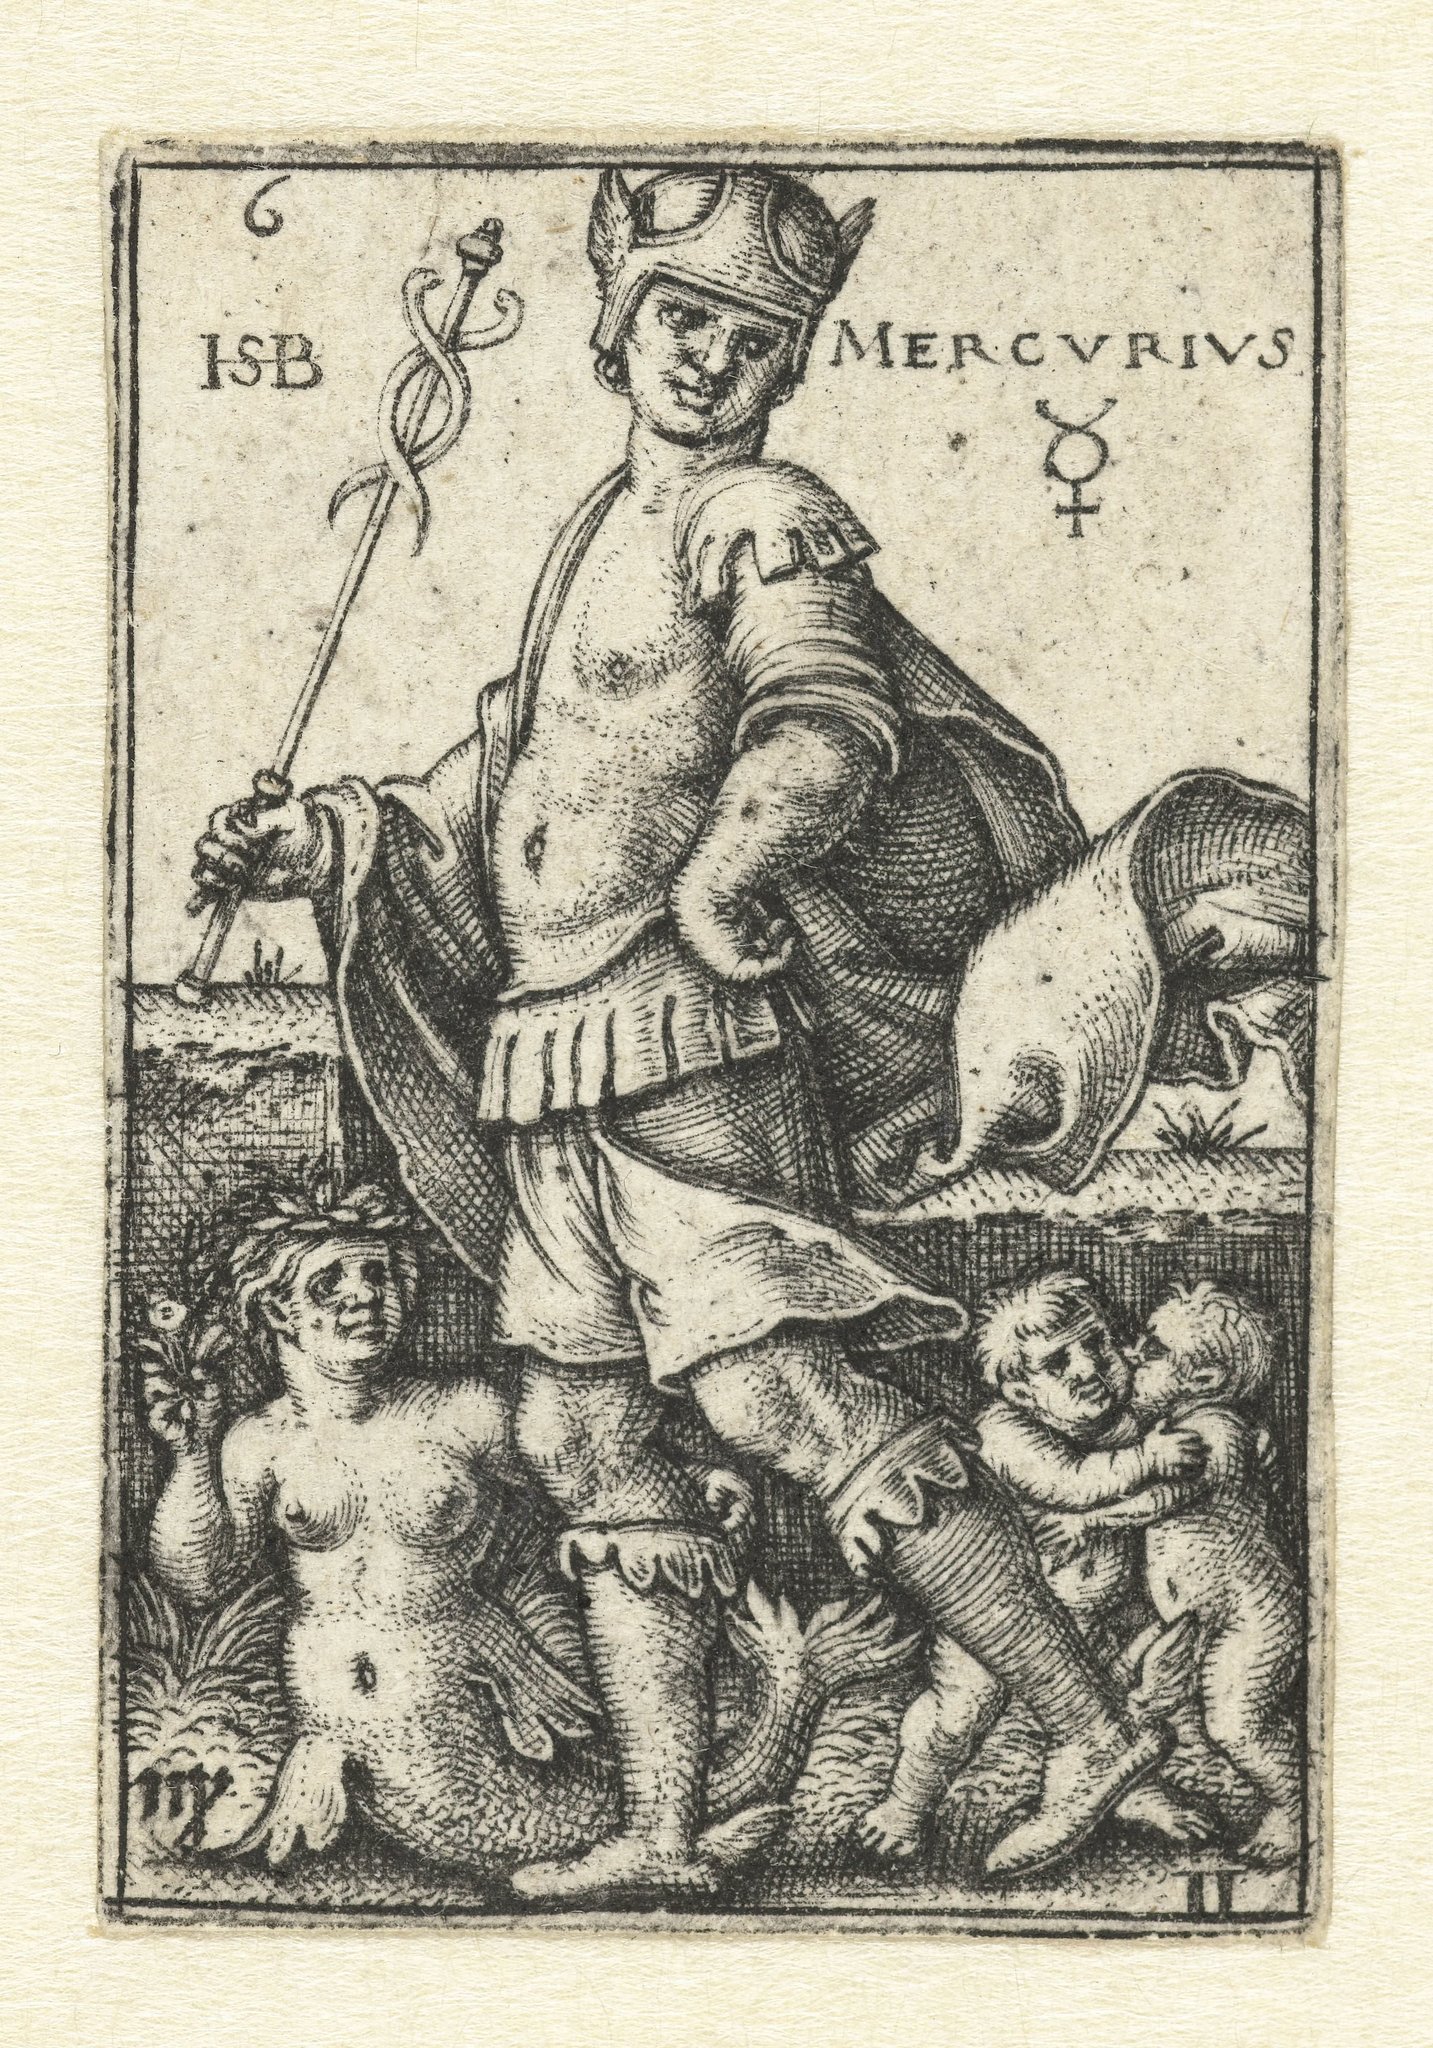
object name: print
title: Mercurius met sterrenbeelden Maagd en Tweelingen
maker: hans sebald beham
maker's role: designer, draughtsman, print maker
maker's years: 1500-1550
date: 1539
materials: paper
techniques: engraving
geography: frankfurt am main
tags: mercury and his children ('planetenkinder') ~ gemini and virgo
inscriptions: collector's mark: Lugt 2228a